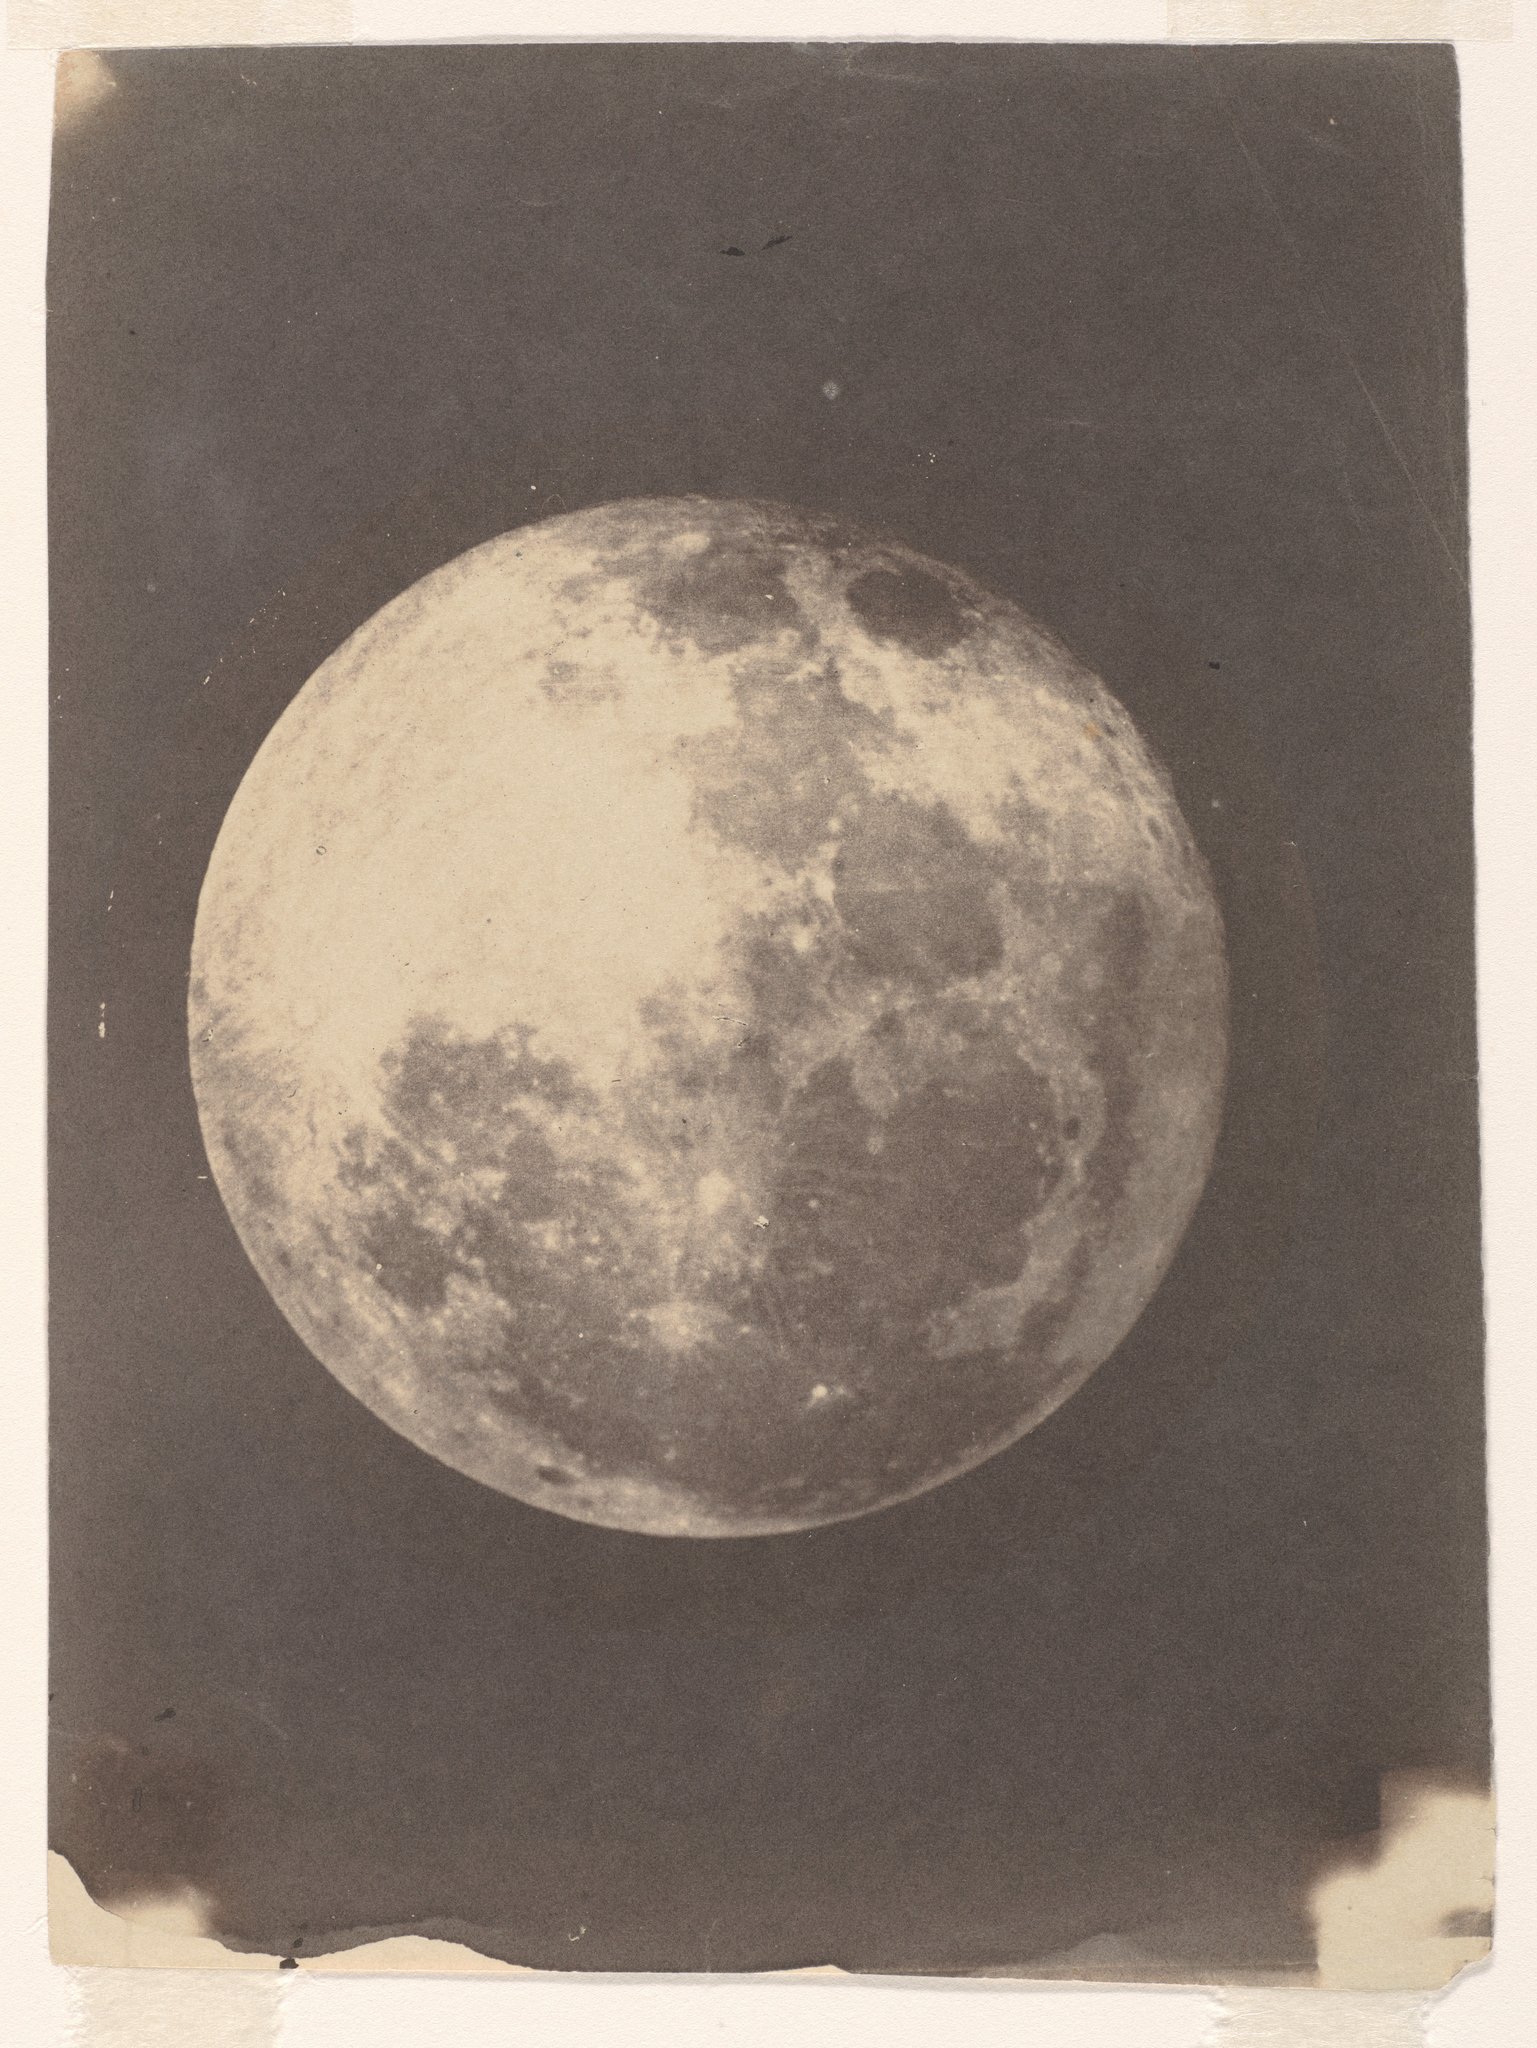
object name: photograph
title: The Moon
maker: john adams whipple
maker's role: artist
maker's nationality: american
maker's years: 1822-1891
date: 1857-1860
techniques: glass negative, salted paper print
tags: moon,astronomy